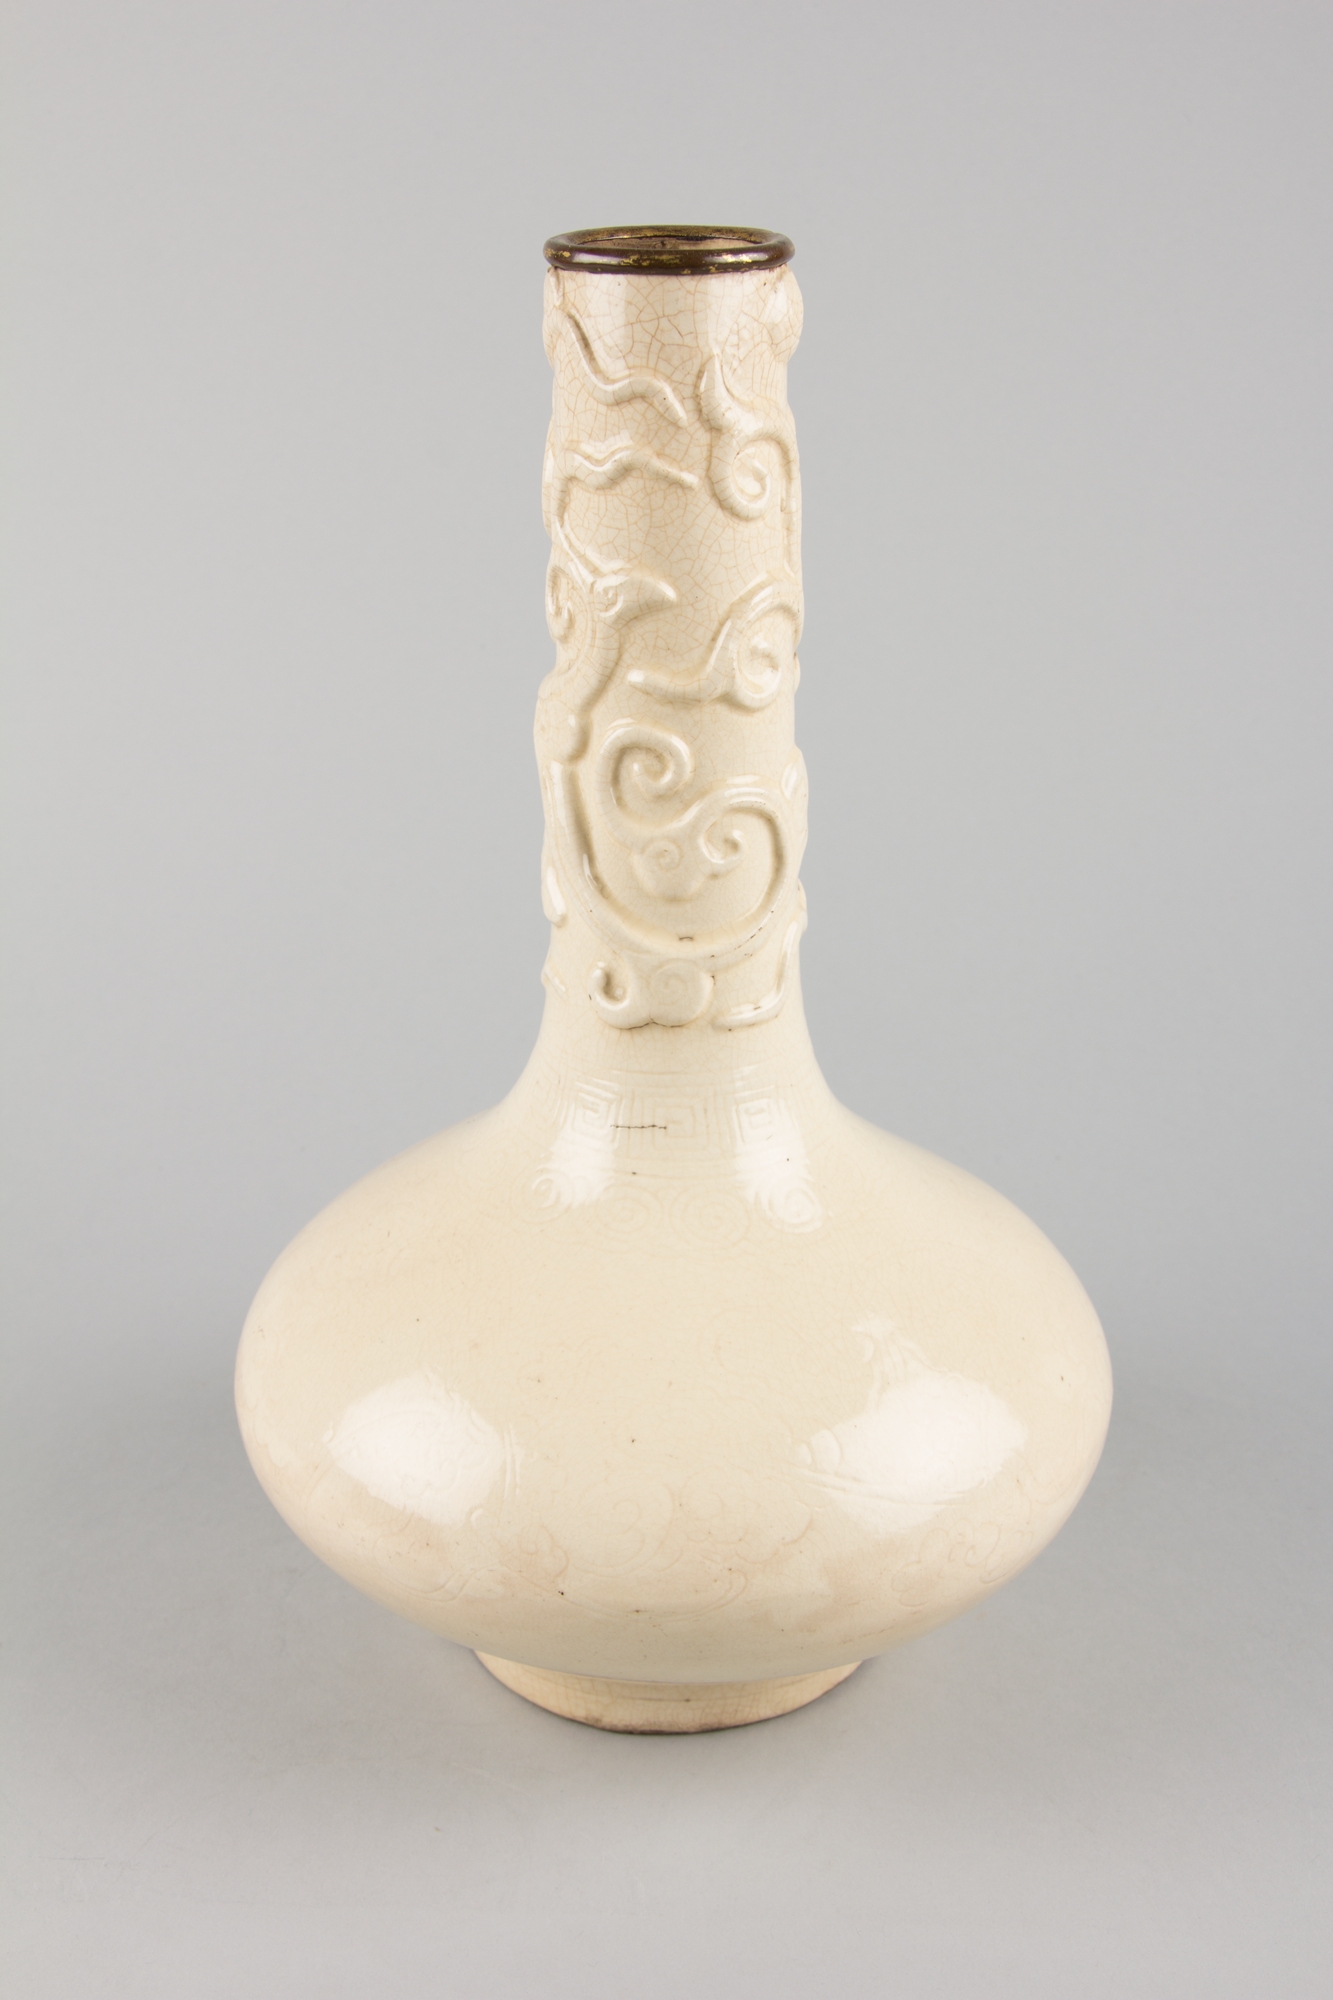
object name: bottle vase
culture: chinese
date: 1701-1800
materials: porcelain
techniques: incising, relief